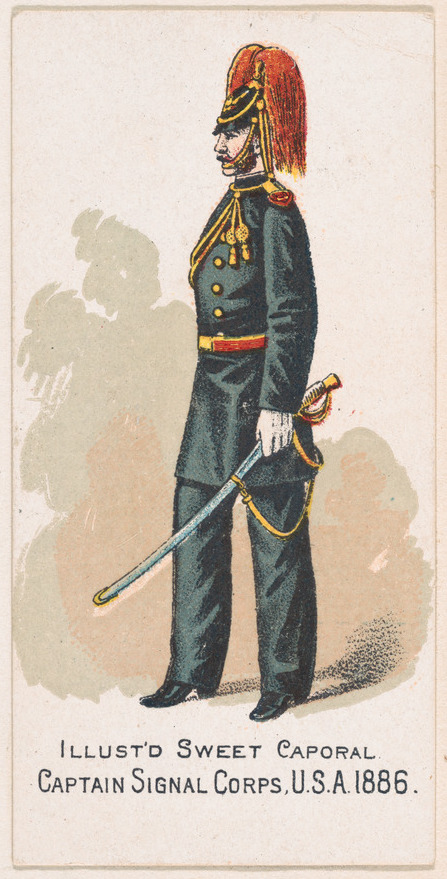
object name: print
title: Captain, Signal Corps, United States Army, 1886, from the Military Series (N224) issued by Kinney Tobacco Company to promote Sweet Caporal Cigarettes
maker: kinney brothers tobacco company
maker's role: publisher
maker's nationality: american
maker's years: 1869-2011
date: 1888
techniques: color lithograph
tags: military,men,profiles